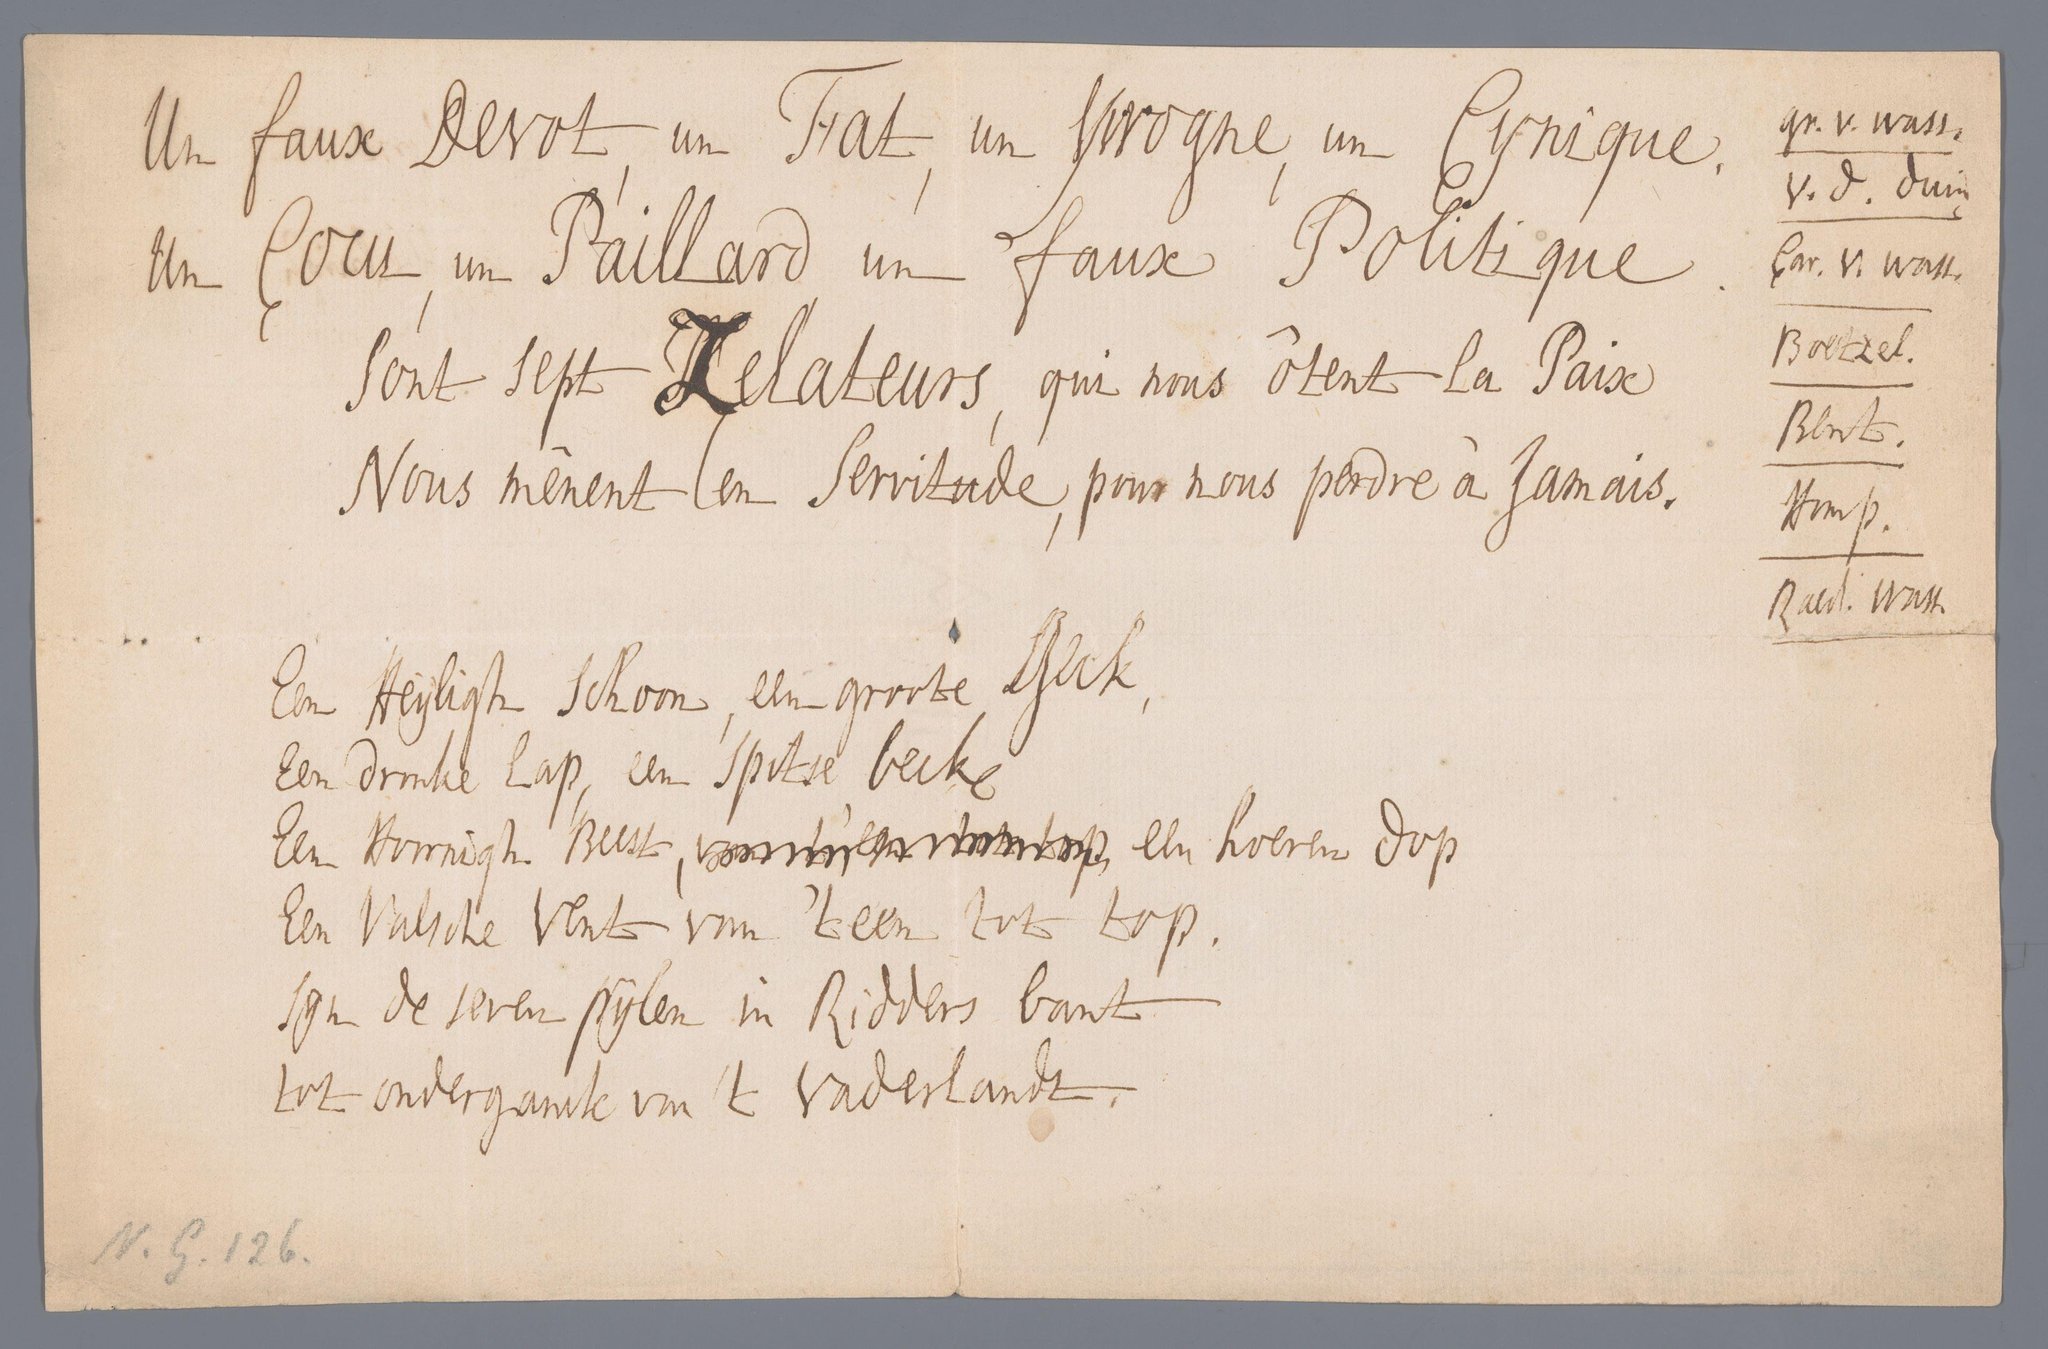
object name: poem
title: Un faux Devot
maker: Anonymous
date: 1775-1800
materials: ink, paper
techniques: writing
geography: netherlands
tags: the hague, adam françois jules armand van der duyn, amsterdam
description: Twee handgeschreven gedichten, op een vel, één in het Frans, de andere in het Nederlands, aan een zijde, een tekst aan de andere zijde. Schimpdicht op drie Van Wassenaars, Van der Duyn, Boetzelaar, Bentinck en Hompesch. Tekst: voor: "Un faux Devot" tot "..tot ondergangck van 't Vaderlandt" achter "geboren........Sonderregt".